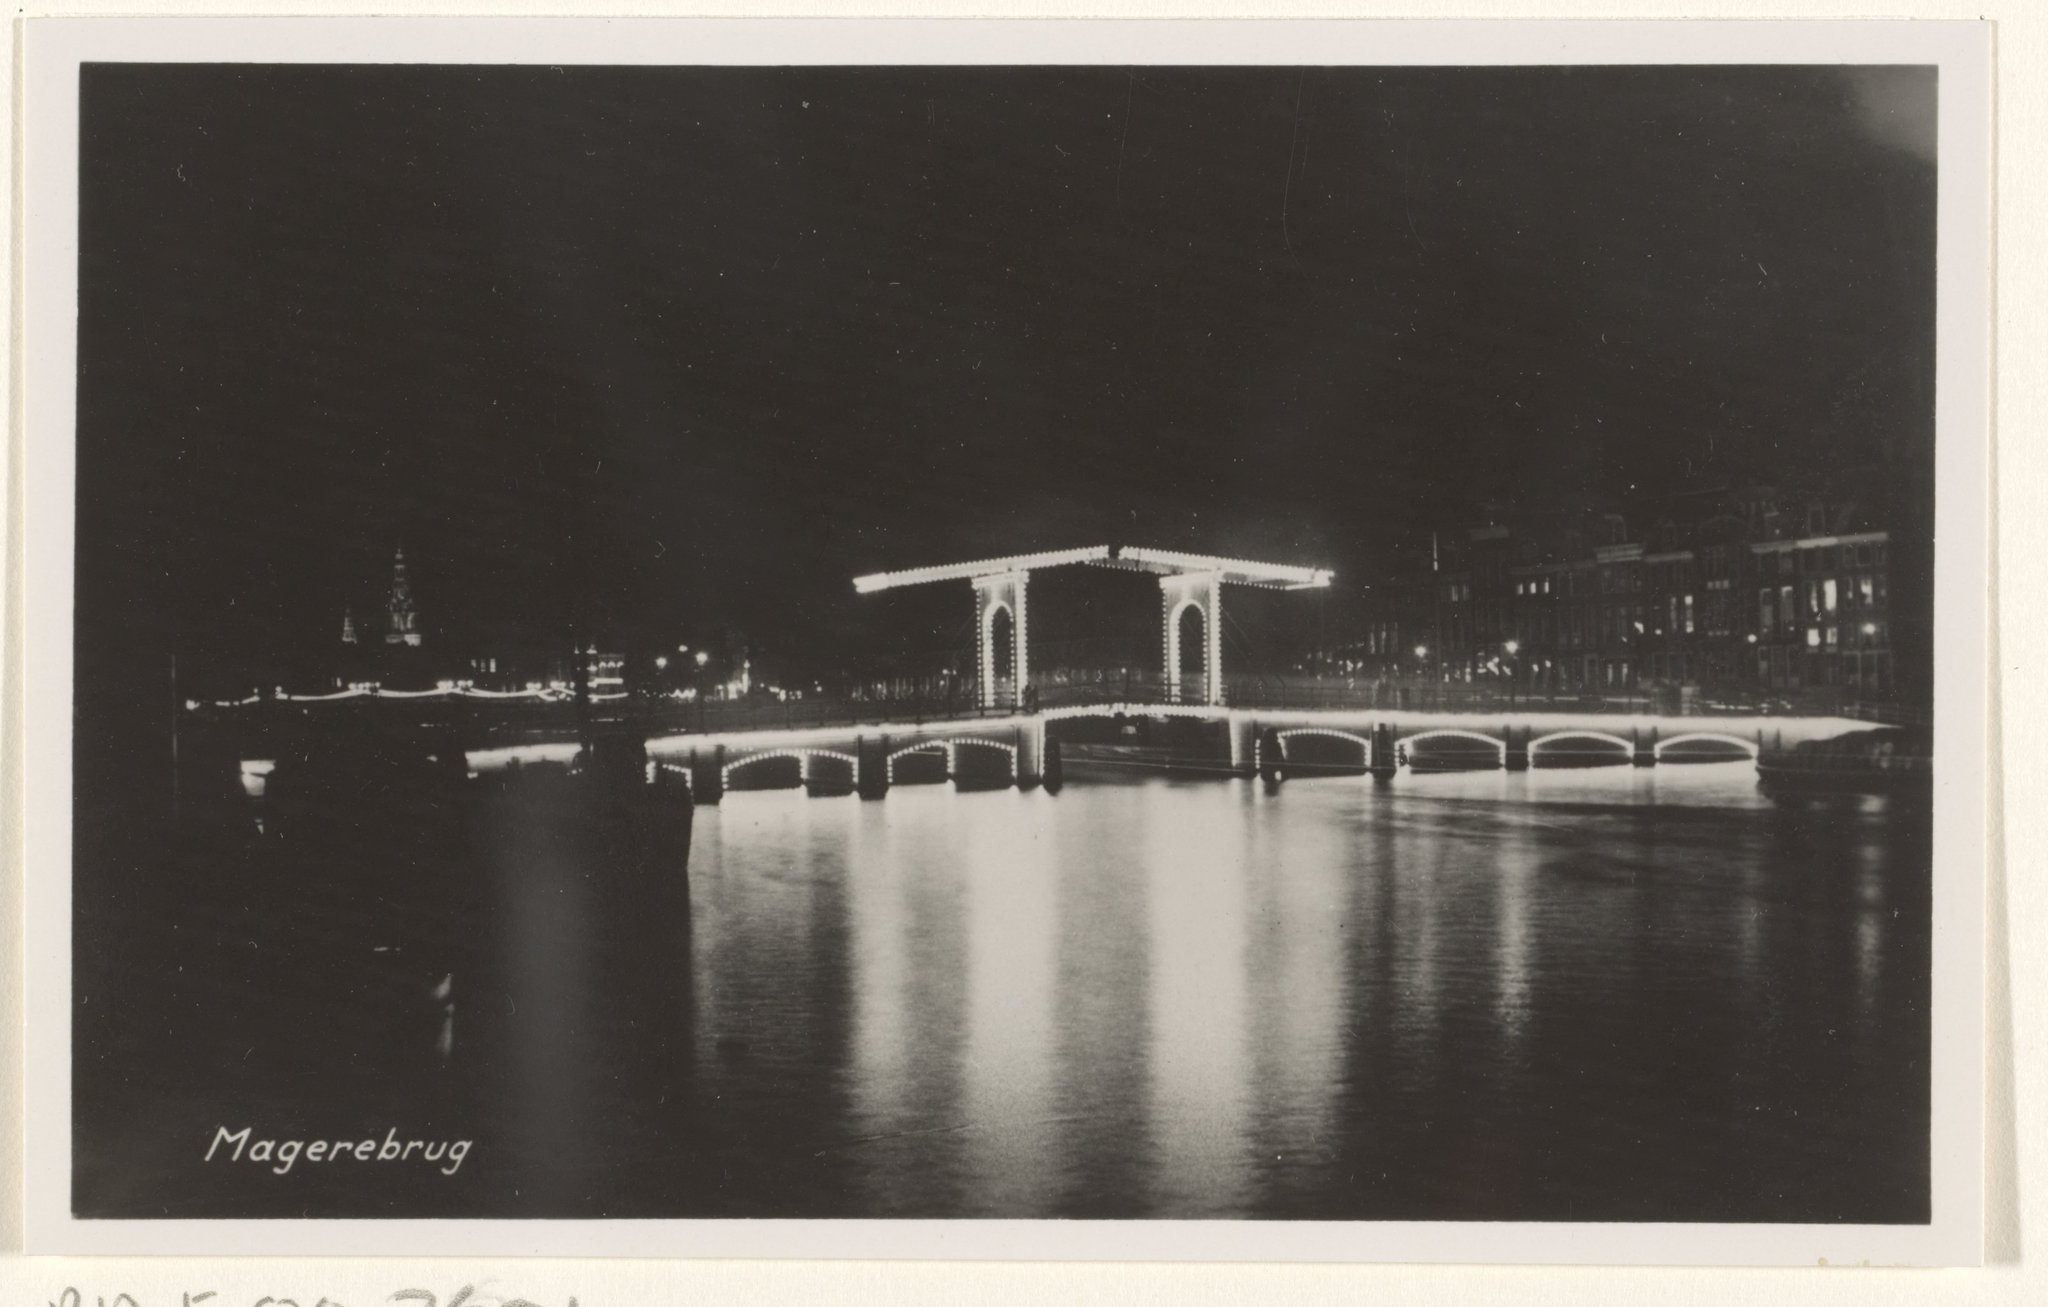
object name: photograph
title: Magere Brug te Amsterdam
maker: Anonymous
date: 1948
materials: photographic support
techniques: photography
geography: netherlands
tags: magere brug